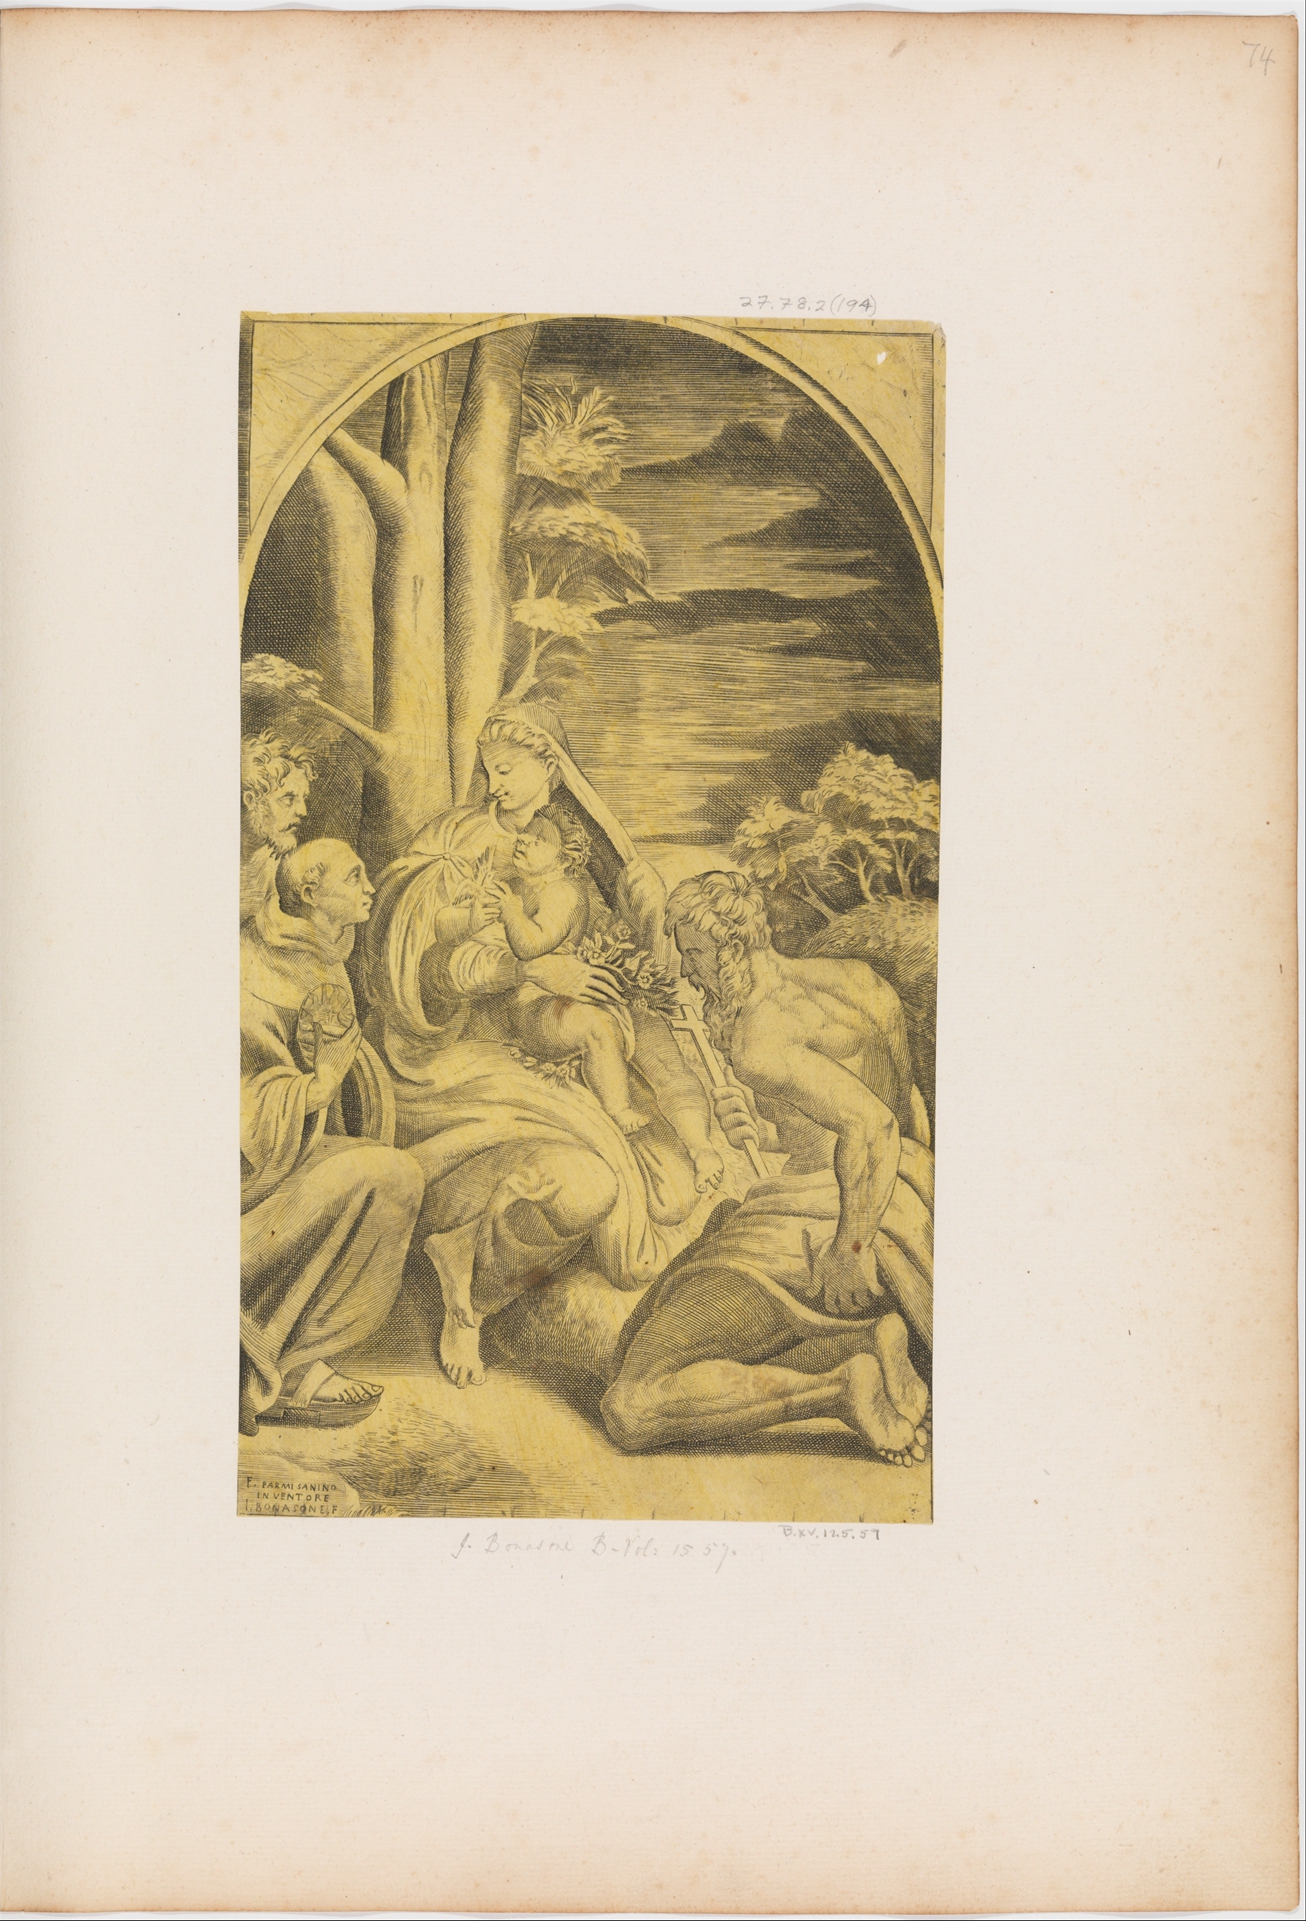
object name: print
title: The Madonna and Child with St. Bernardino of Sienna and St. Jerome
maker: giulio bonasone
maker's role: artist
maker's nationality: italian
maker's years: 1510-1576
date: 1510-1576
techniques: engraving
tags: madonna and child,saint jerome,saints